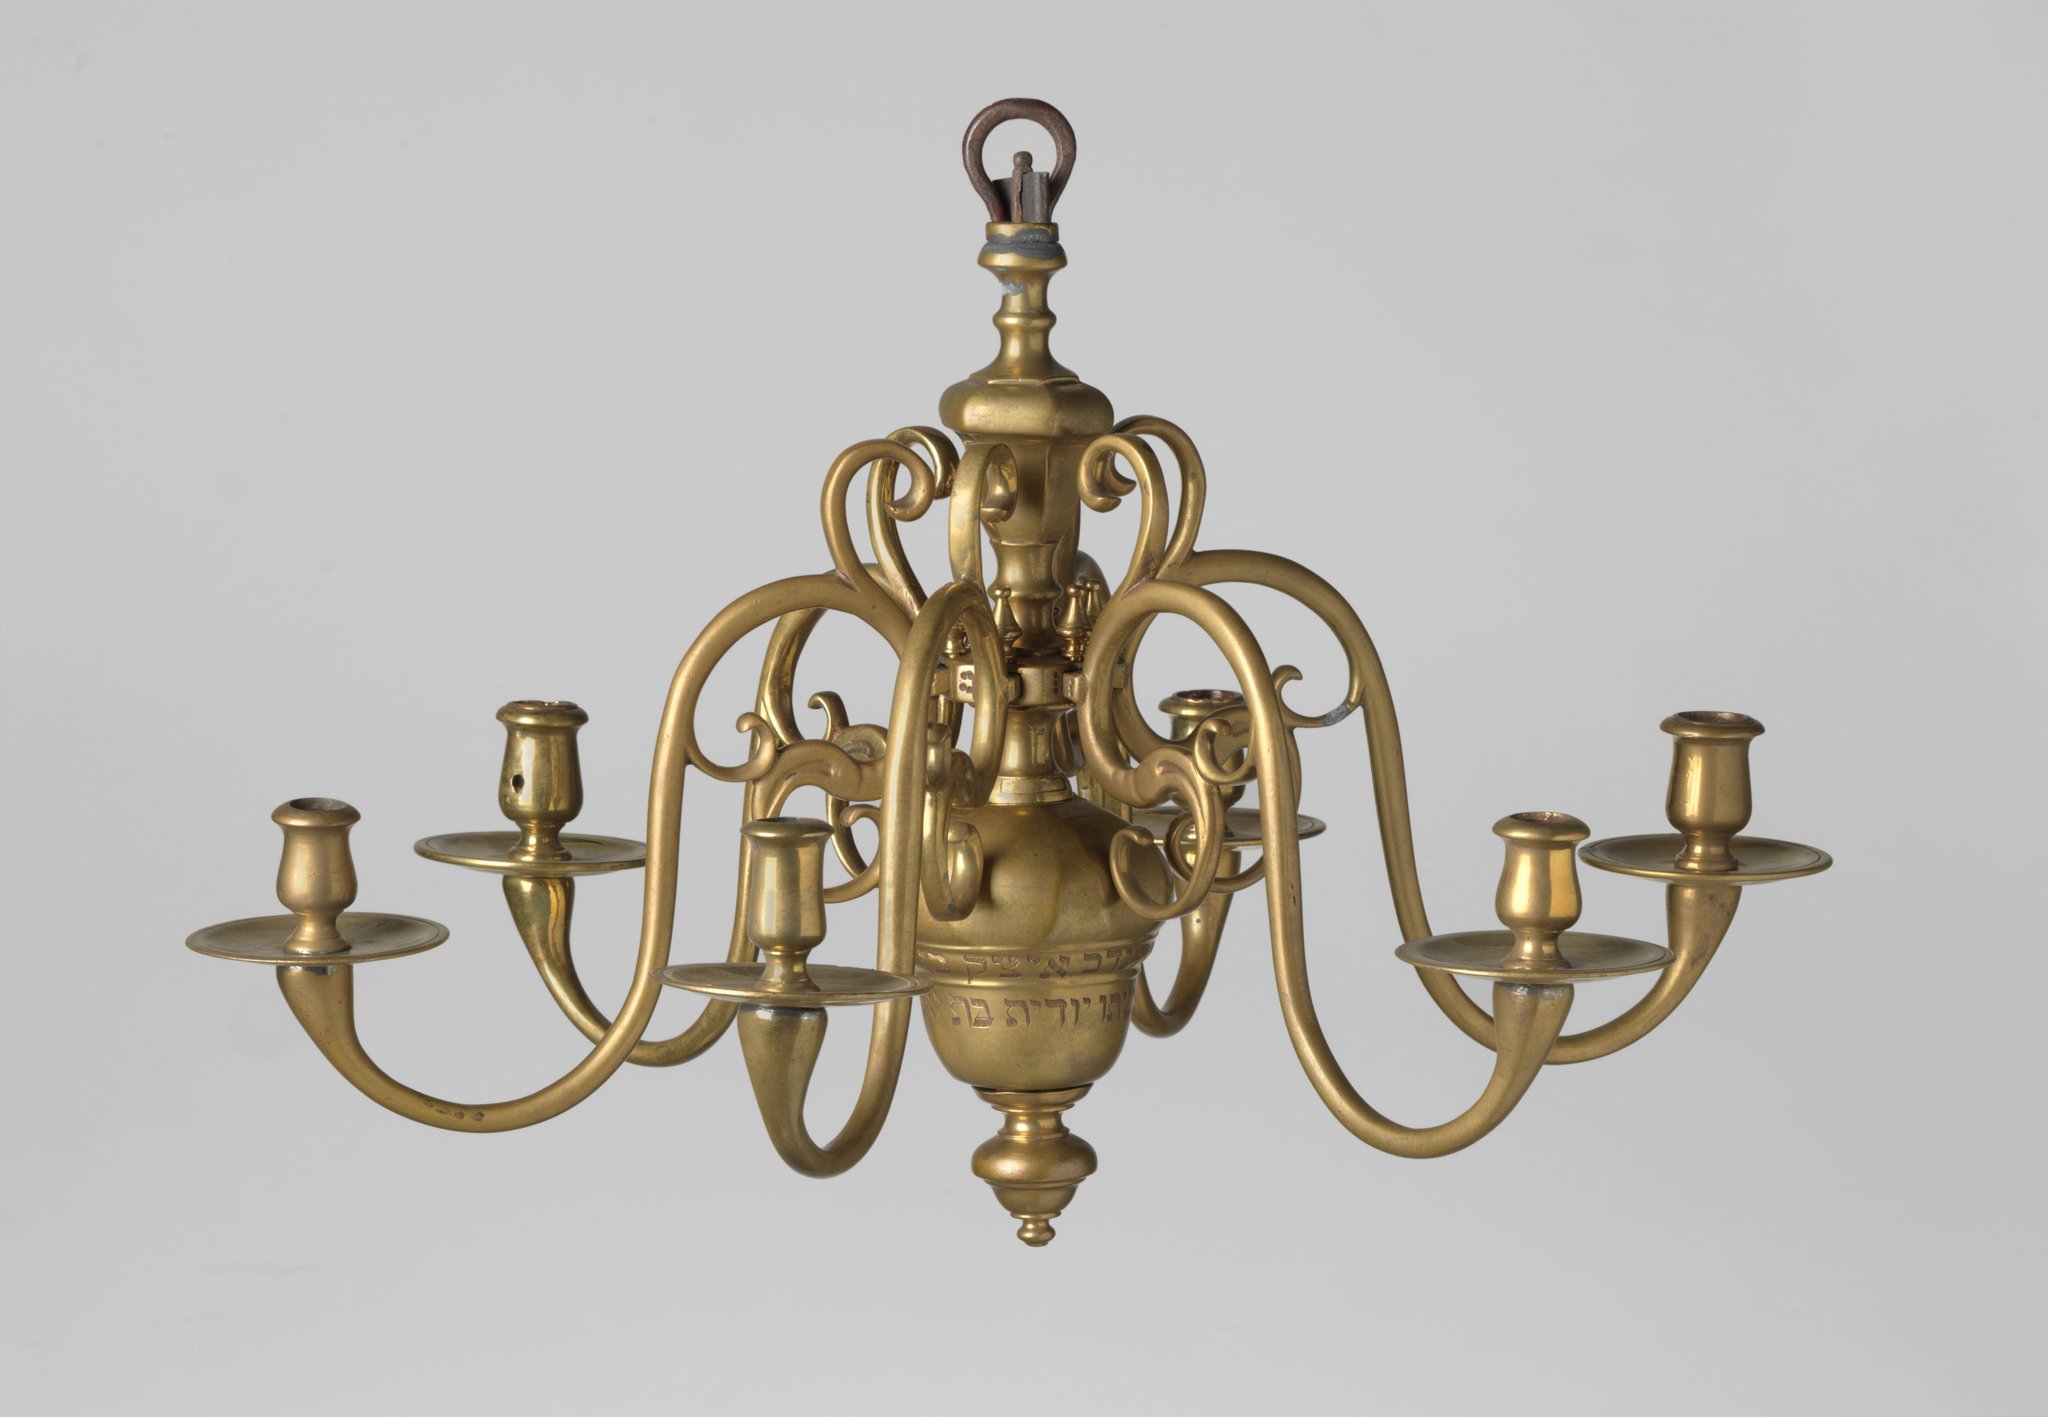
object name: chandelier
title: Bevestigingspinnen van kaarsenkroon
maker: Anonymous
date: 1795-1800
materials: brass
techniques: casting, screwed, turning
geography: amsterdam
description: Zes bevestigingspinnen van messing van een kaarsenkroon met een knop bovenop.